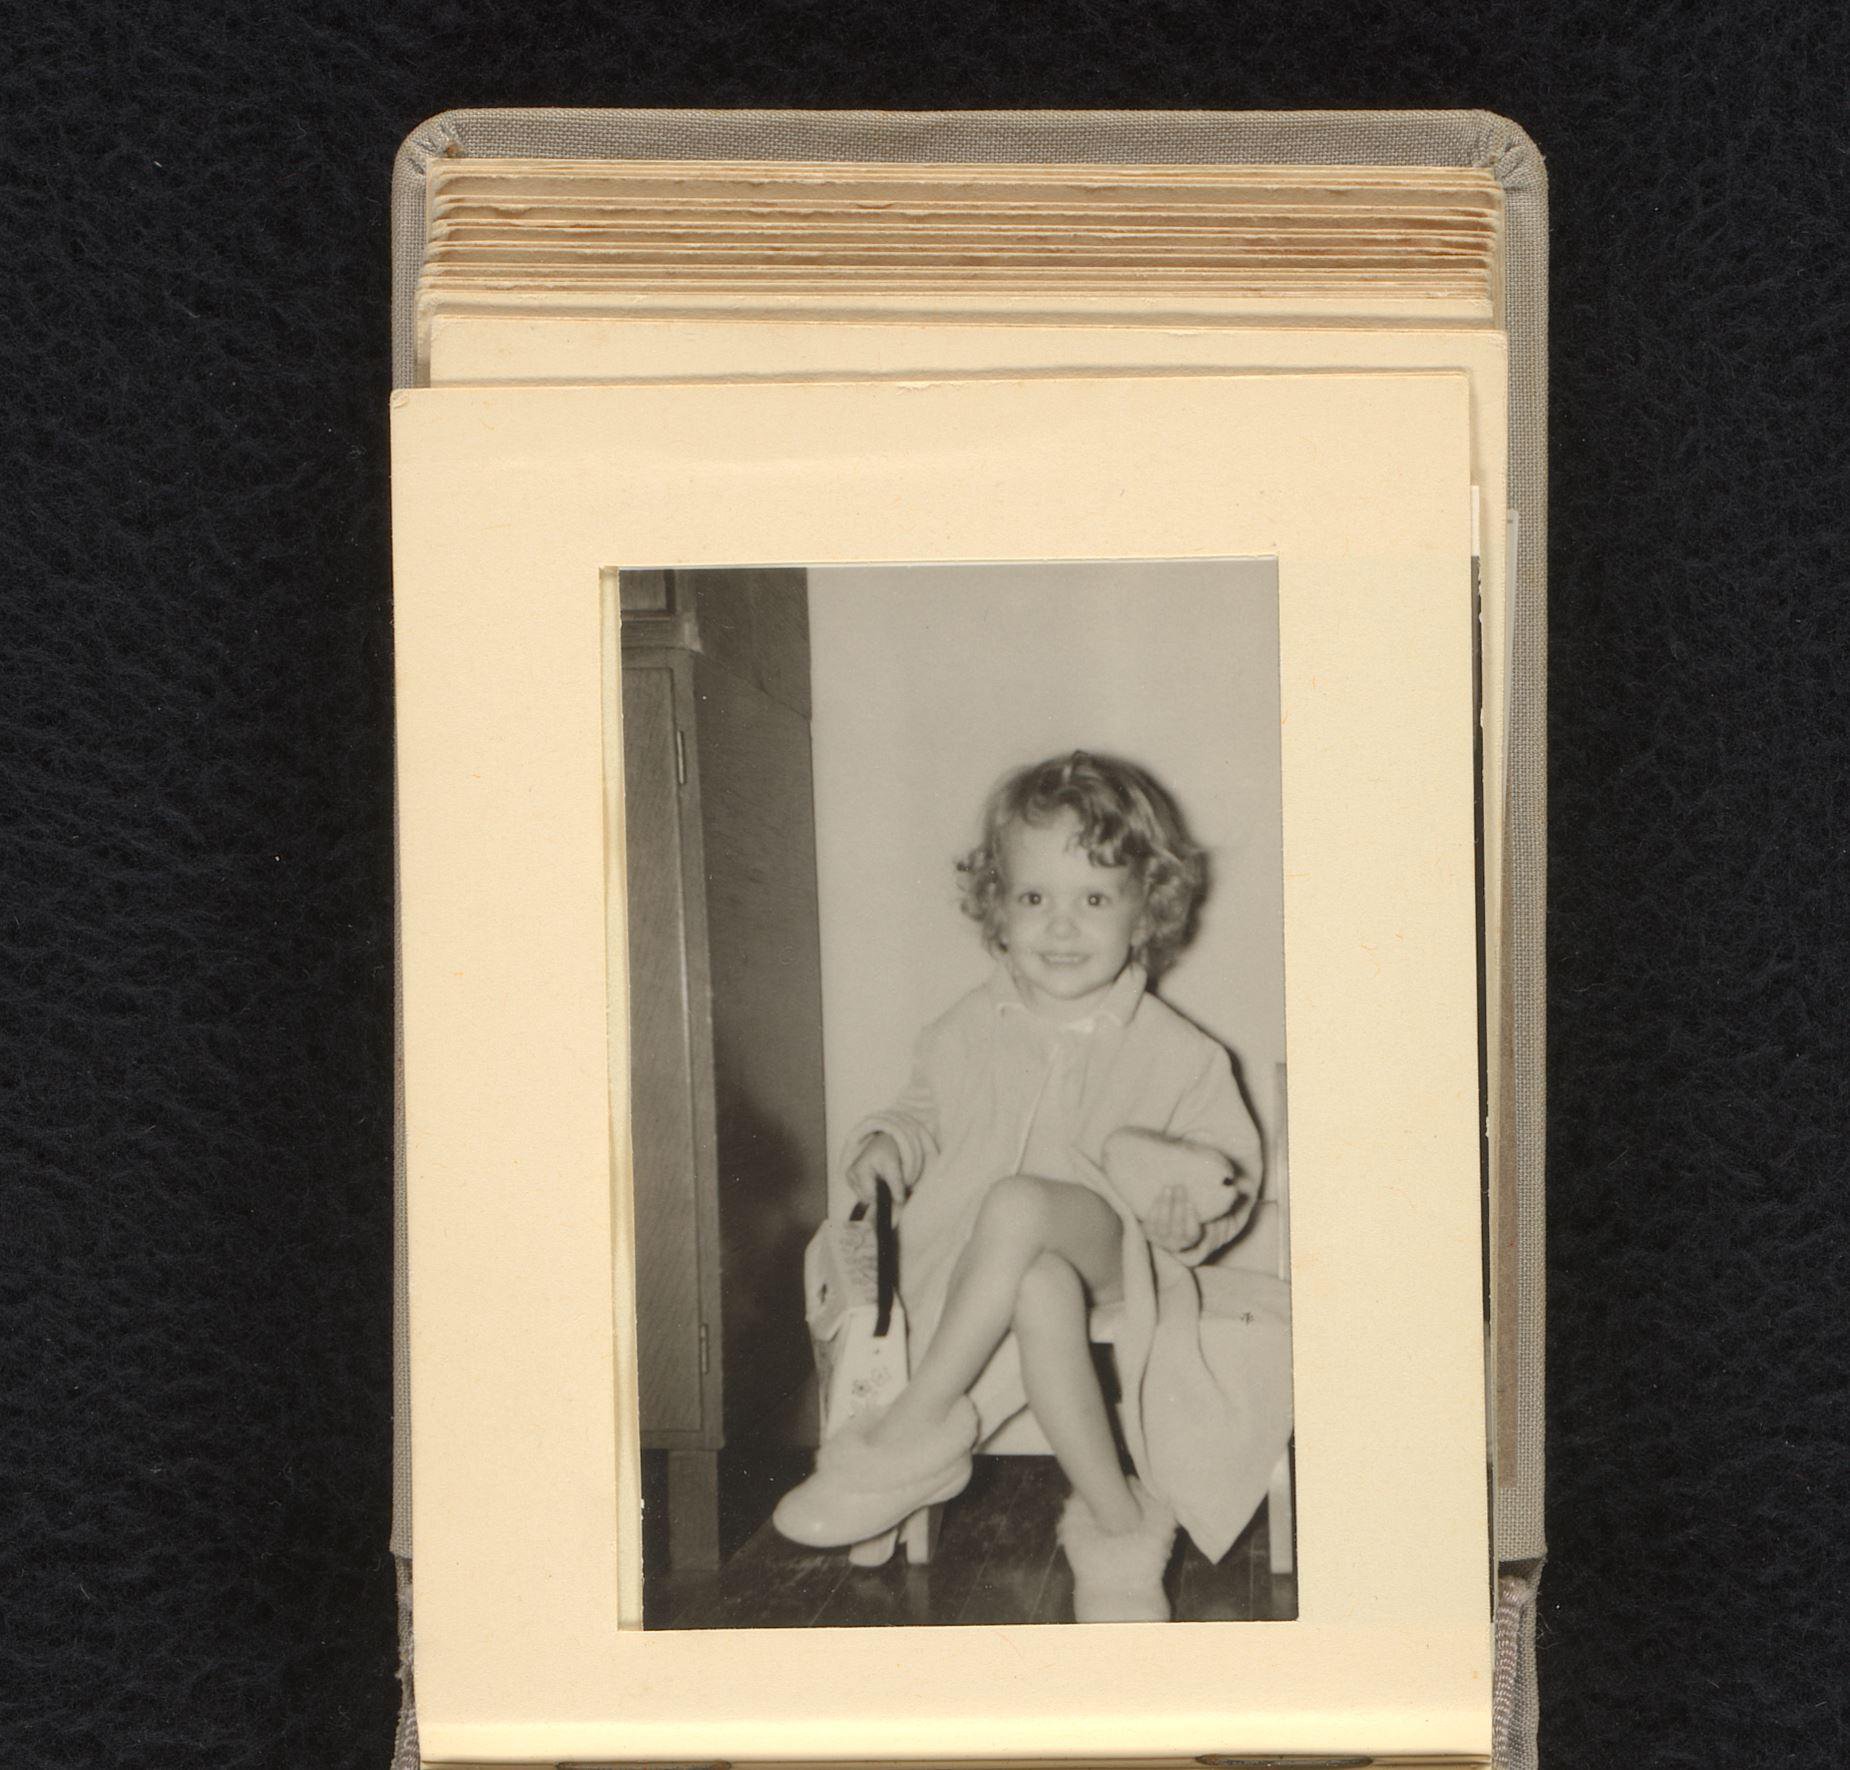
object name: photograph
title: Onbekend meisje zit op een stoel, 1956-1970?, Verenigde Staten?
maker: isabel wachenheimer-elon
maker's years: 1928-2010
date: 1956-1970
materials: paper, photographic support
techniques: gelatin silver print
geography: united states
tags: historical persons not known by name - bb - woman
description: Albumblad bevat een foto van onbekend meisje. Onderdeel van het fotoalbum met diverse foto's van de jeugd van Isabel Wachenheimer voor en tijdens de oorlog en diverse momenten van haar volwassen leven na de Tweede Wereldoorlog.